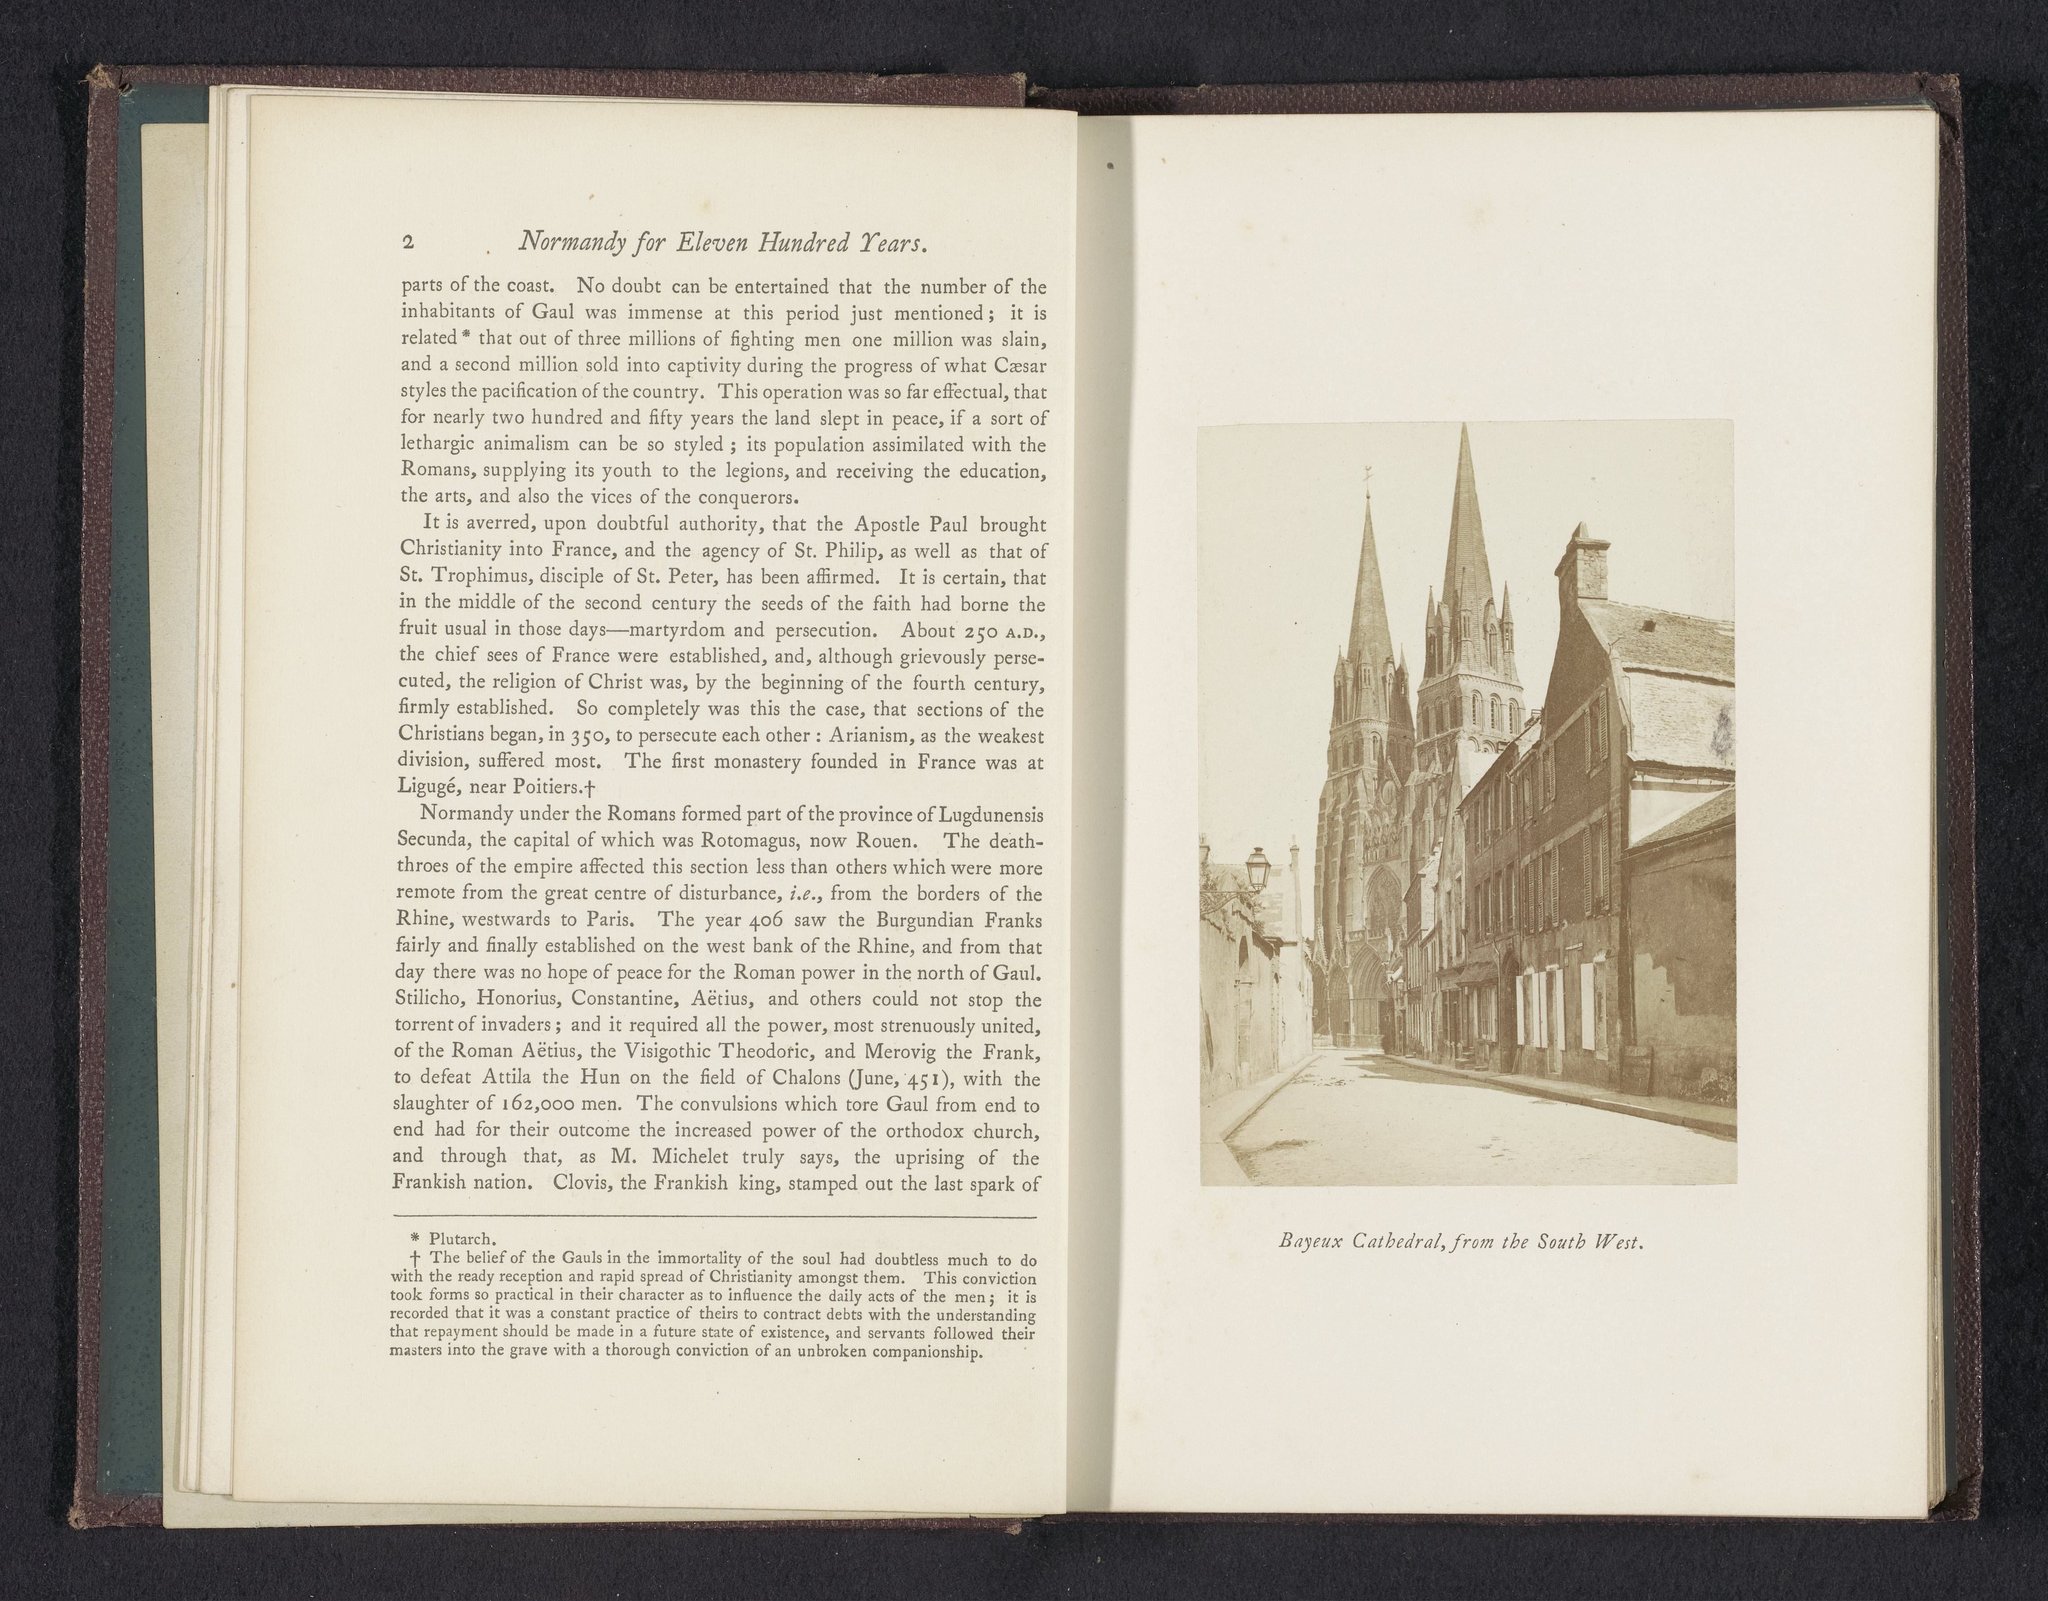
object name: photograph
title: Bayeux Cathedral, from the South West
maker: joseph cundall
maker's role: fotograaf, schrijver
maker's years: 1818-1895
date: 1855-1865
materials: photographic support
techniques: albumen print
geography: bayeux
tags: church (exterior), façade (of house or building)